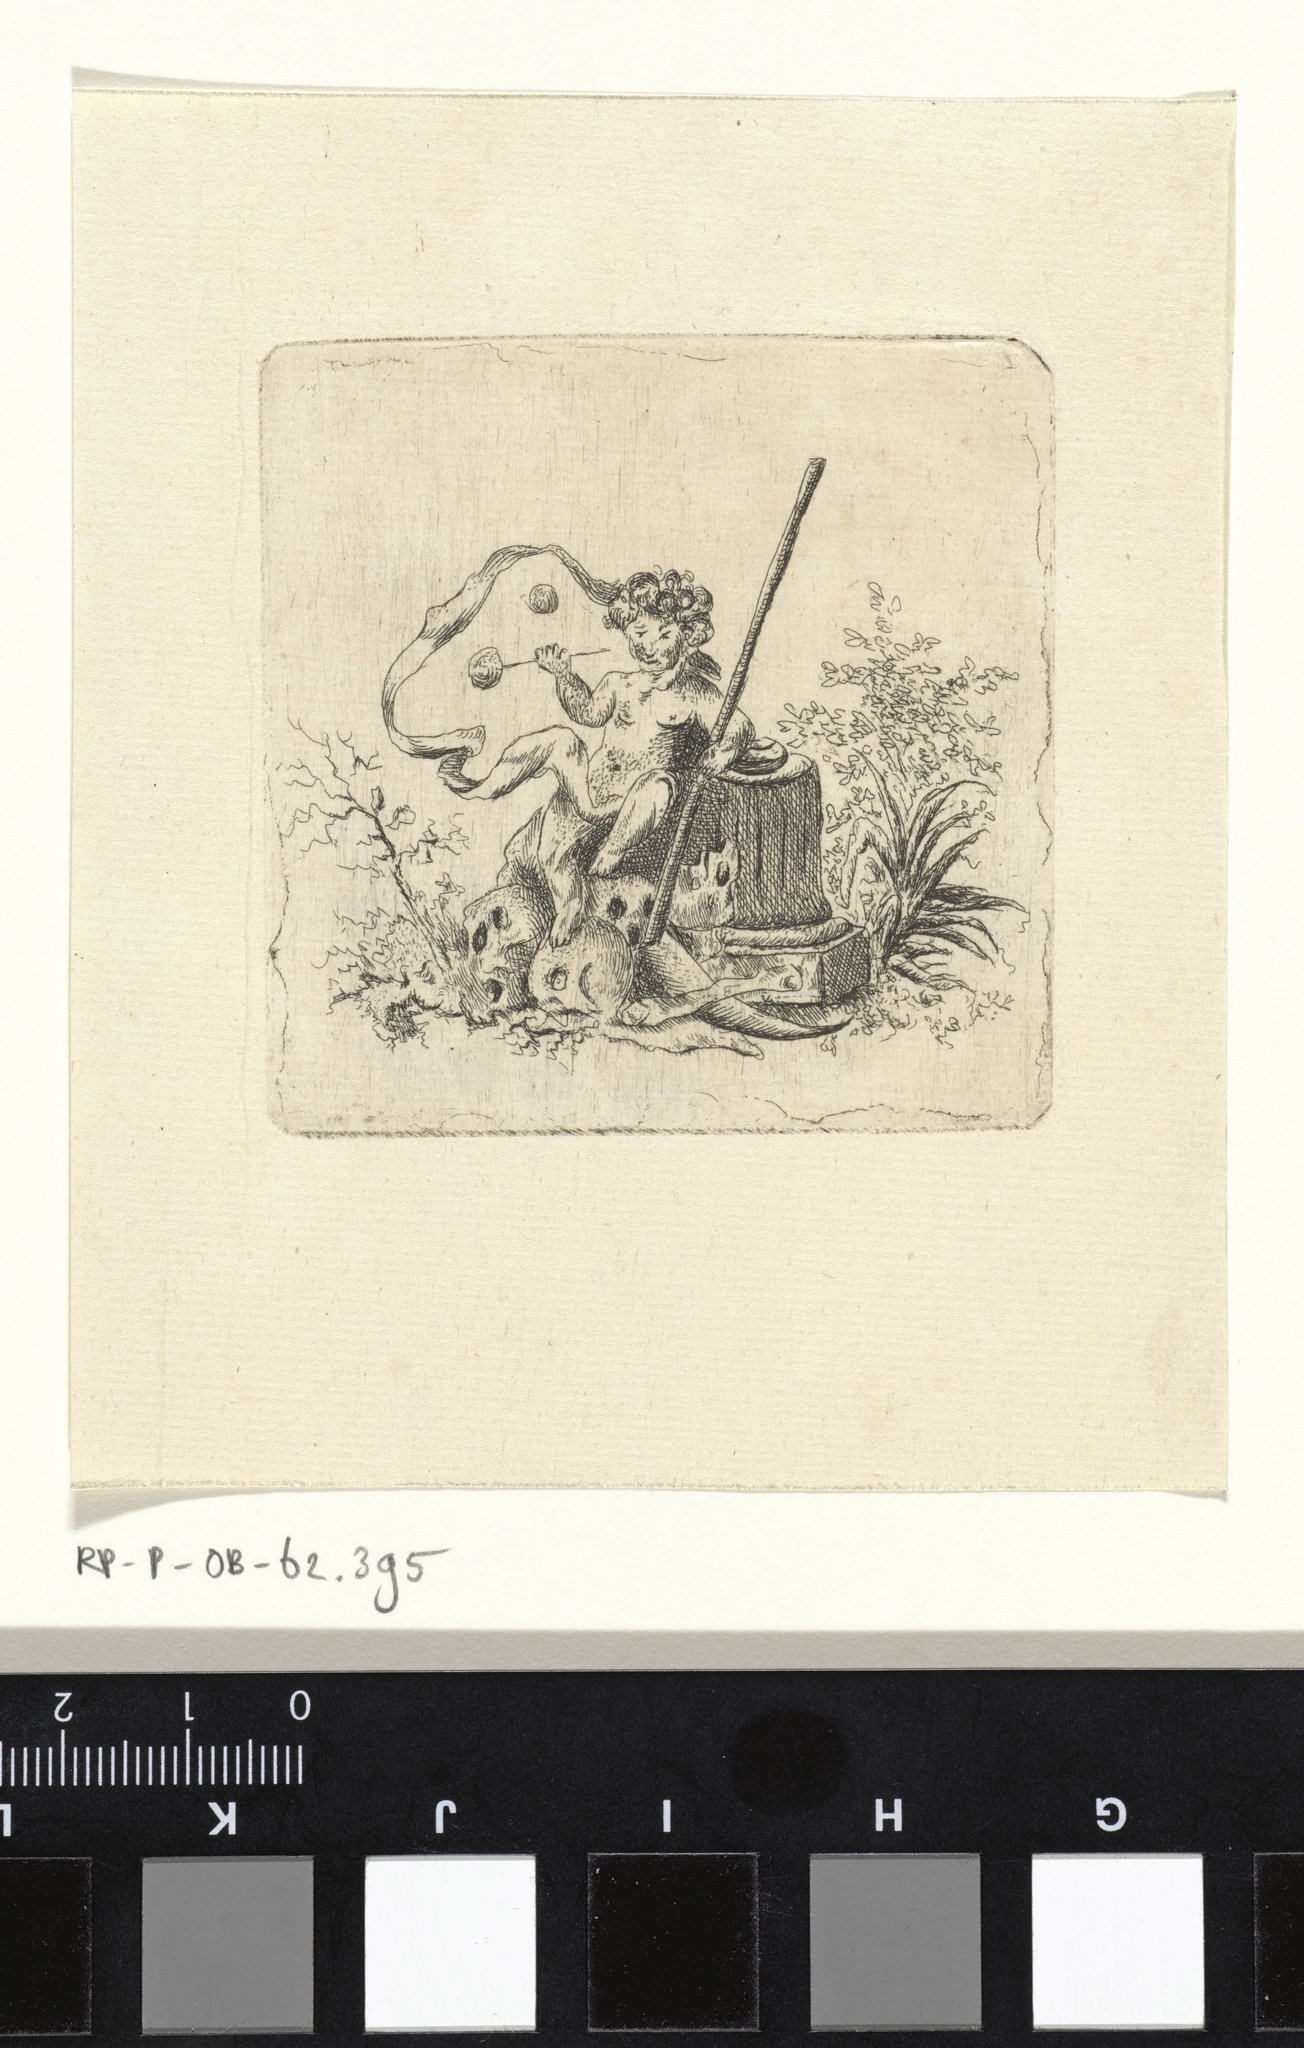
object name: print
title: Bellenblazende putto met een zeis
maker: vincent van der vinne van lee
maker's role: print maker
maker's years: 1798-1876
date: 1808-1876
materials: paper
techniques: engraving, etching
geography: netherlands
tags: skull as symbol of 'vanitas', (children or putti) blowing bubbles, 'homo bulla' ~ scene symbolizing 'vanitas'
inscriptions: collector's mark: Lugt 2227, inscription: ‘Vincent vd Vinne v Lee fec/ cet. 13-’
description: Vanitas: een bellenblazende putto met een zeis in de hand, leunt op een zuil en heeft onder zijn voeten enkele schedels.